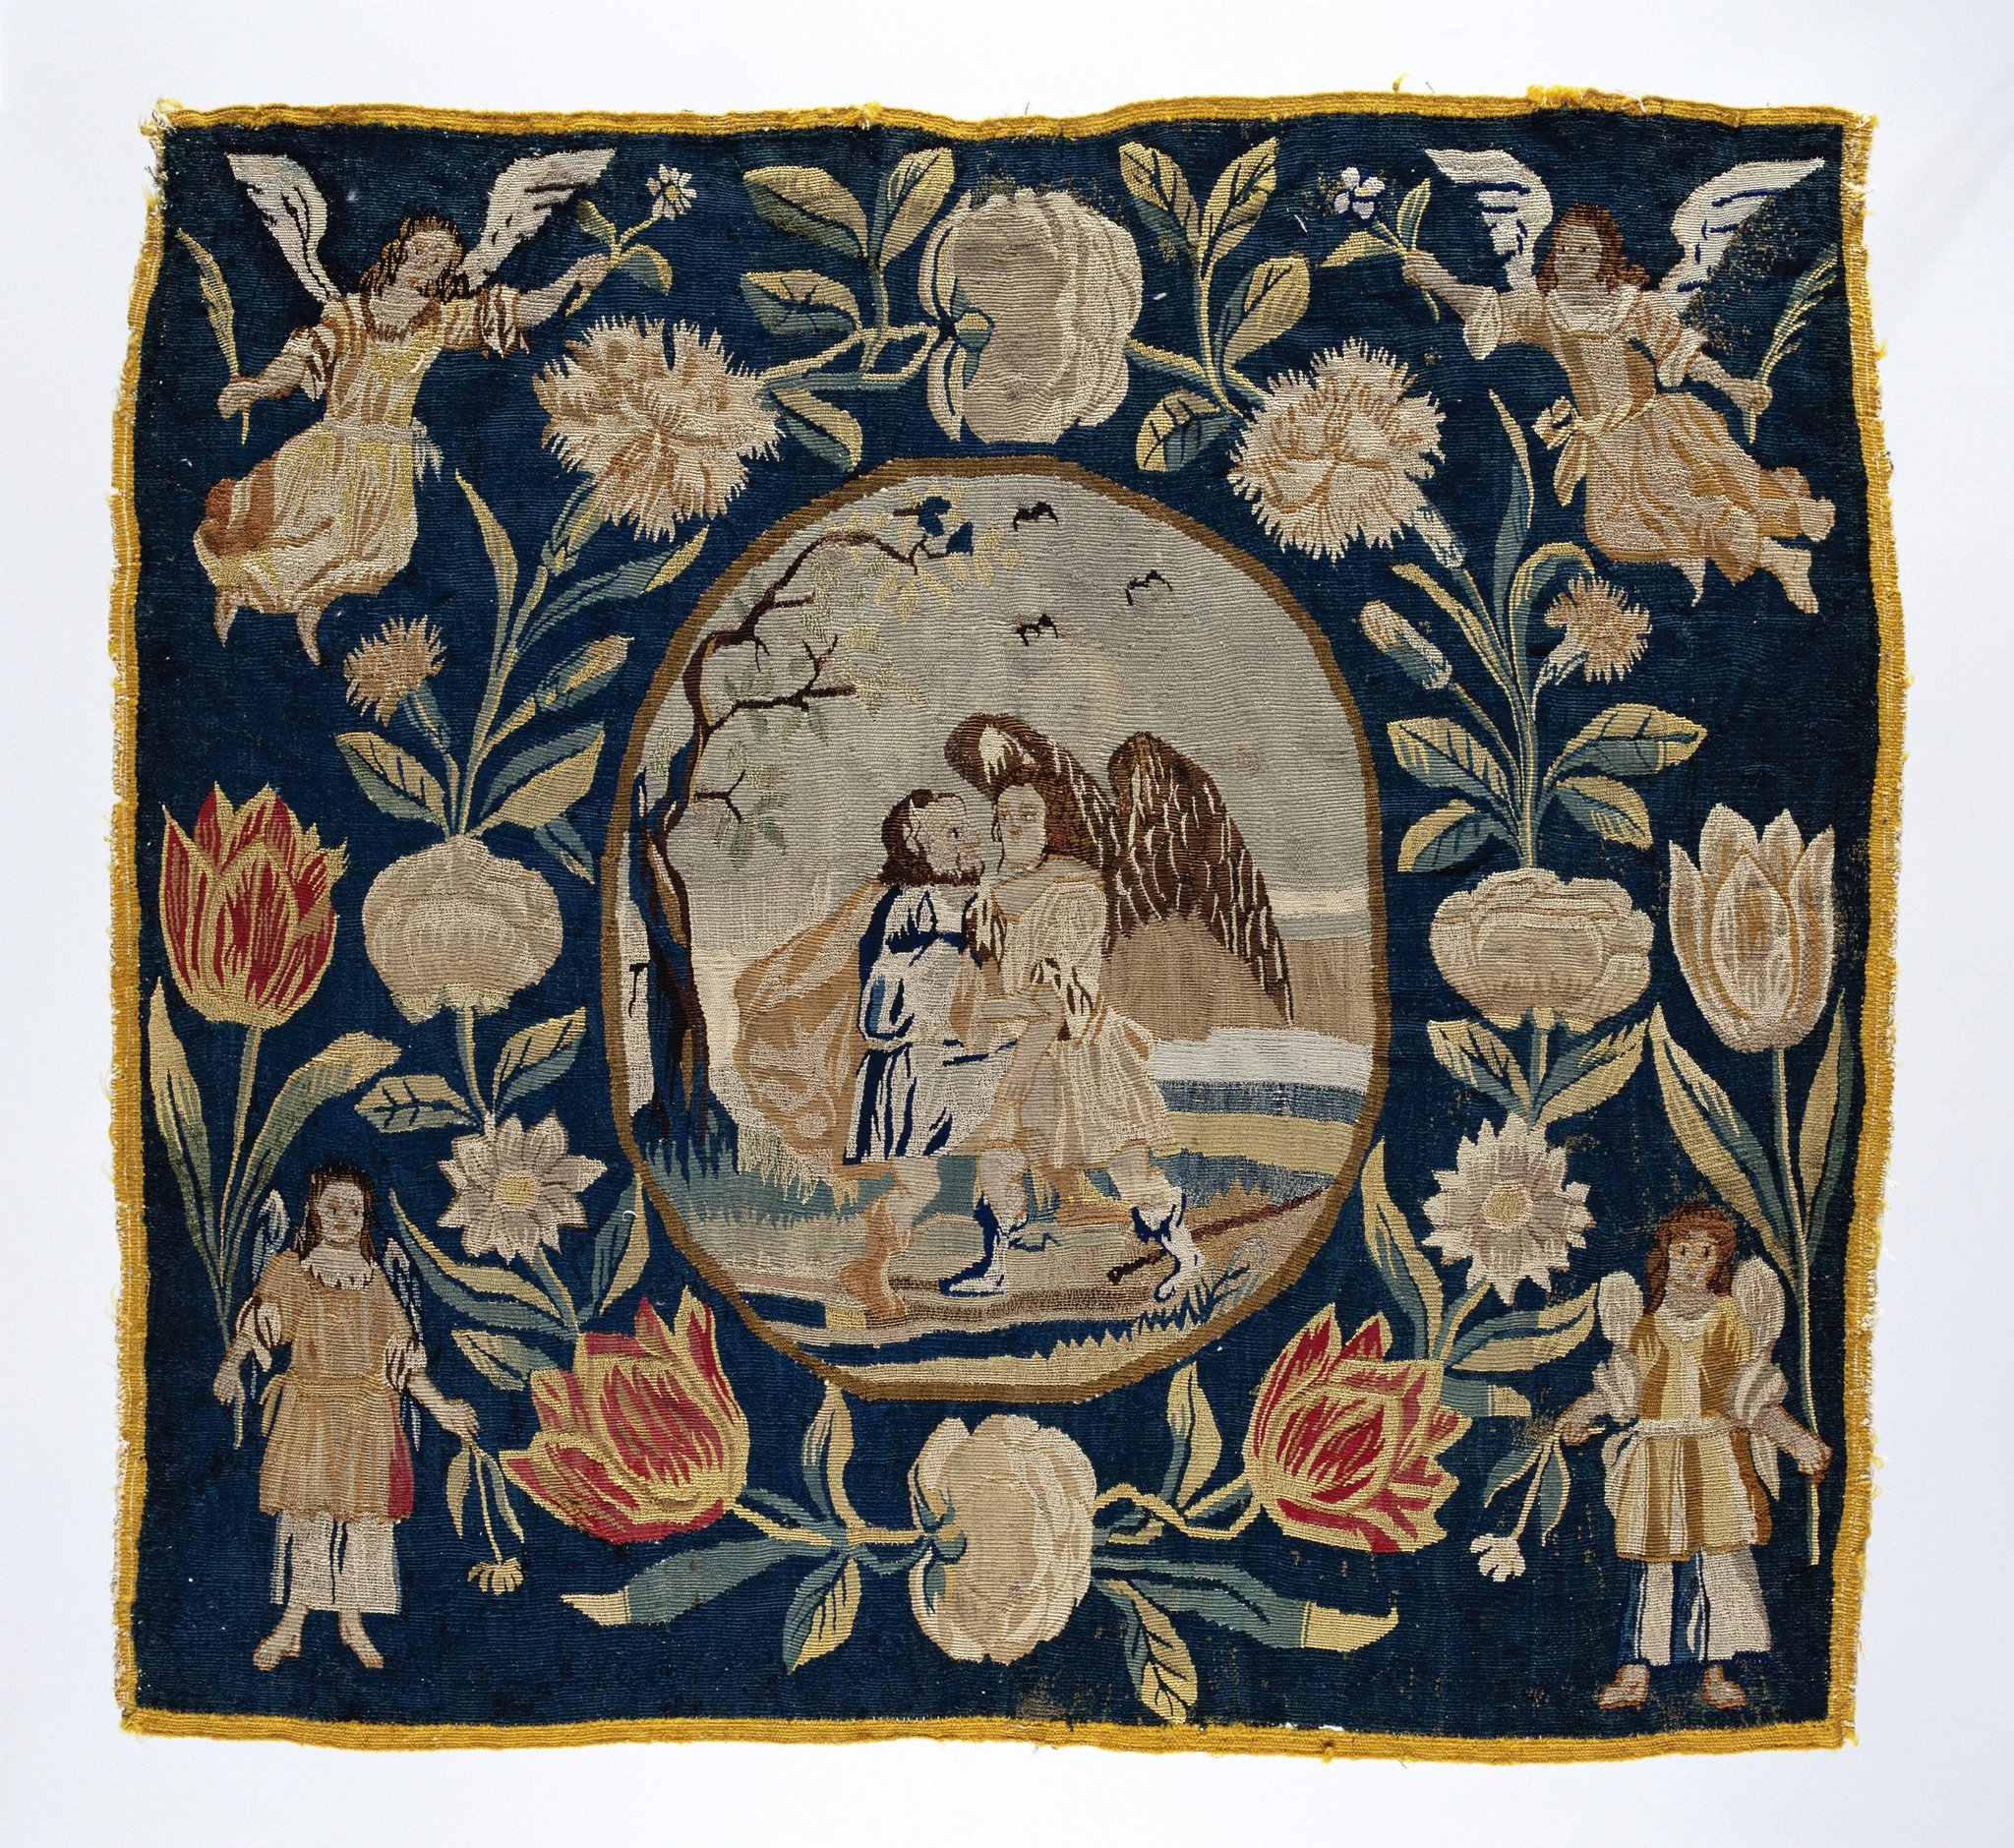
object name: cushion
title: Jacob worstelt met de engel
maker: Anonymous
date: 1660-1675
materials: silk, wool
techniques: tapestry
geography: northern netherlands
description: Kussen van tapijtweefsel met Jacob in gevecht met de engel (Gen. 32:24). Het kussen maakt deel uit van een serie kussens met de geschiedenis van Jacob, waarvan twee andere zich in het Rijksmuseum bevinden.